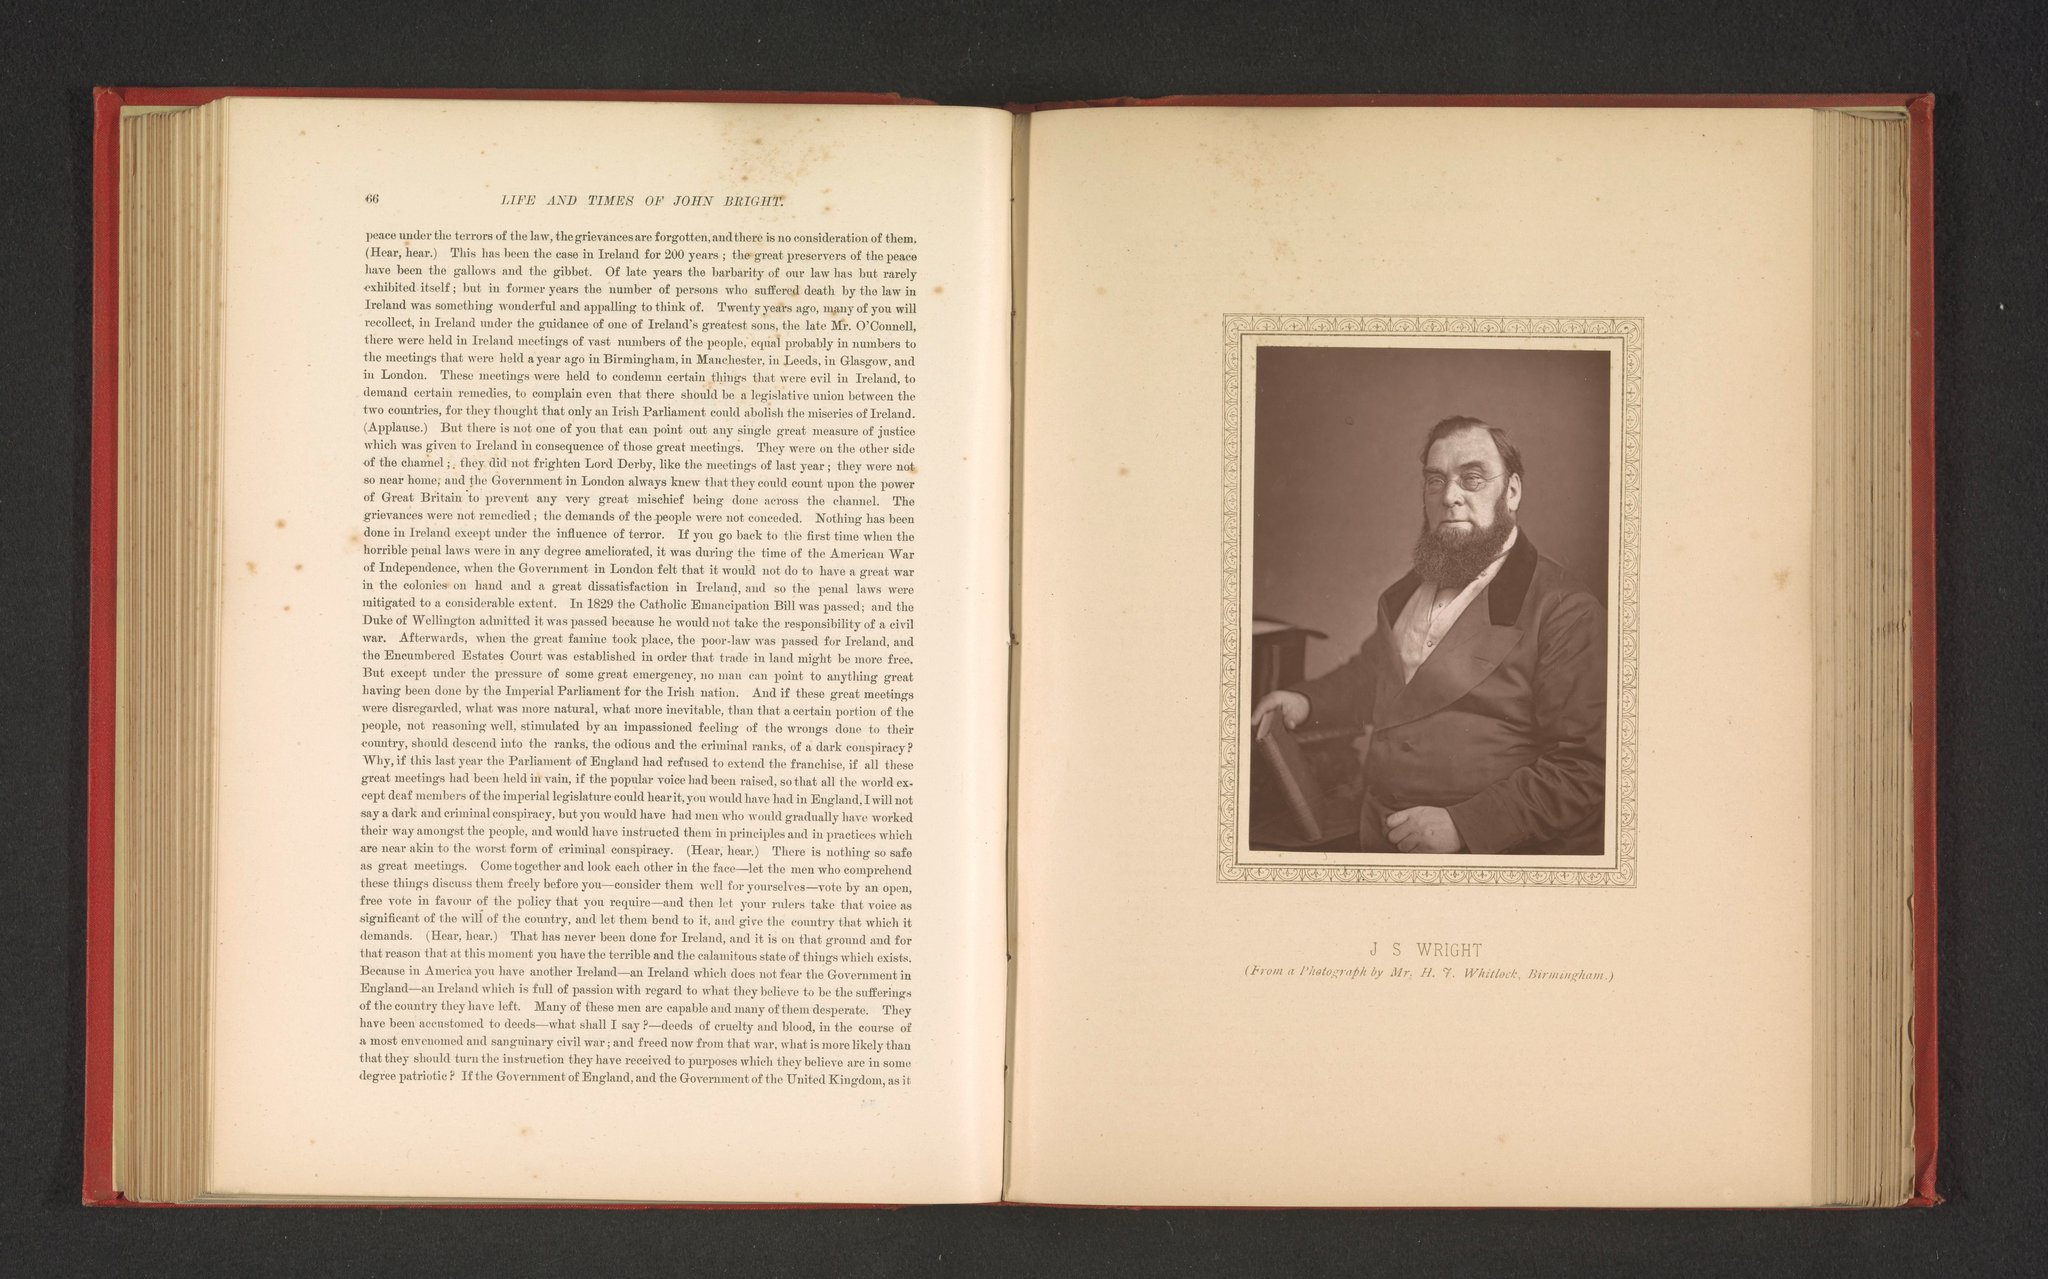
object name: page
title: J.S. Wright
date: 1874-1884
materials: paper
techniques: woodburytype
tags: adult man